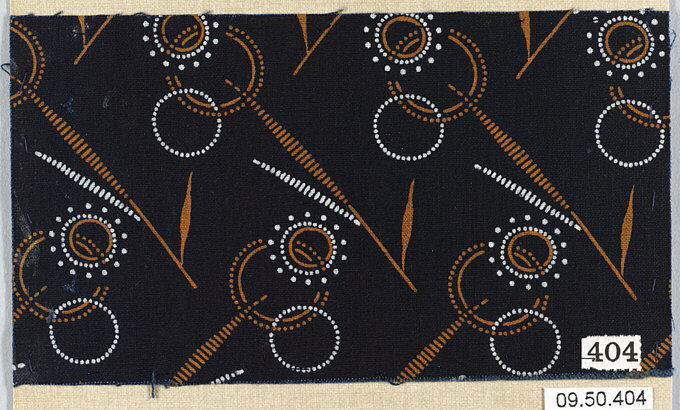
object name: piece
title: Piece (one of 116)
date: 1801-1900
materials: cotton